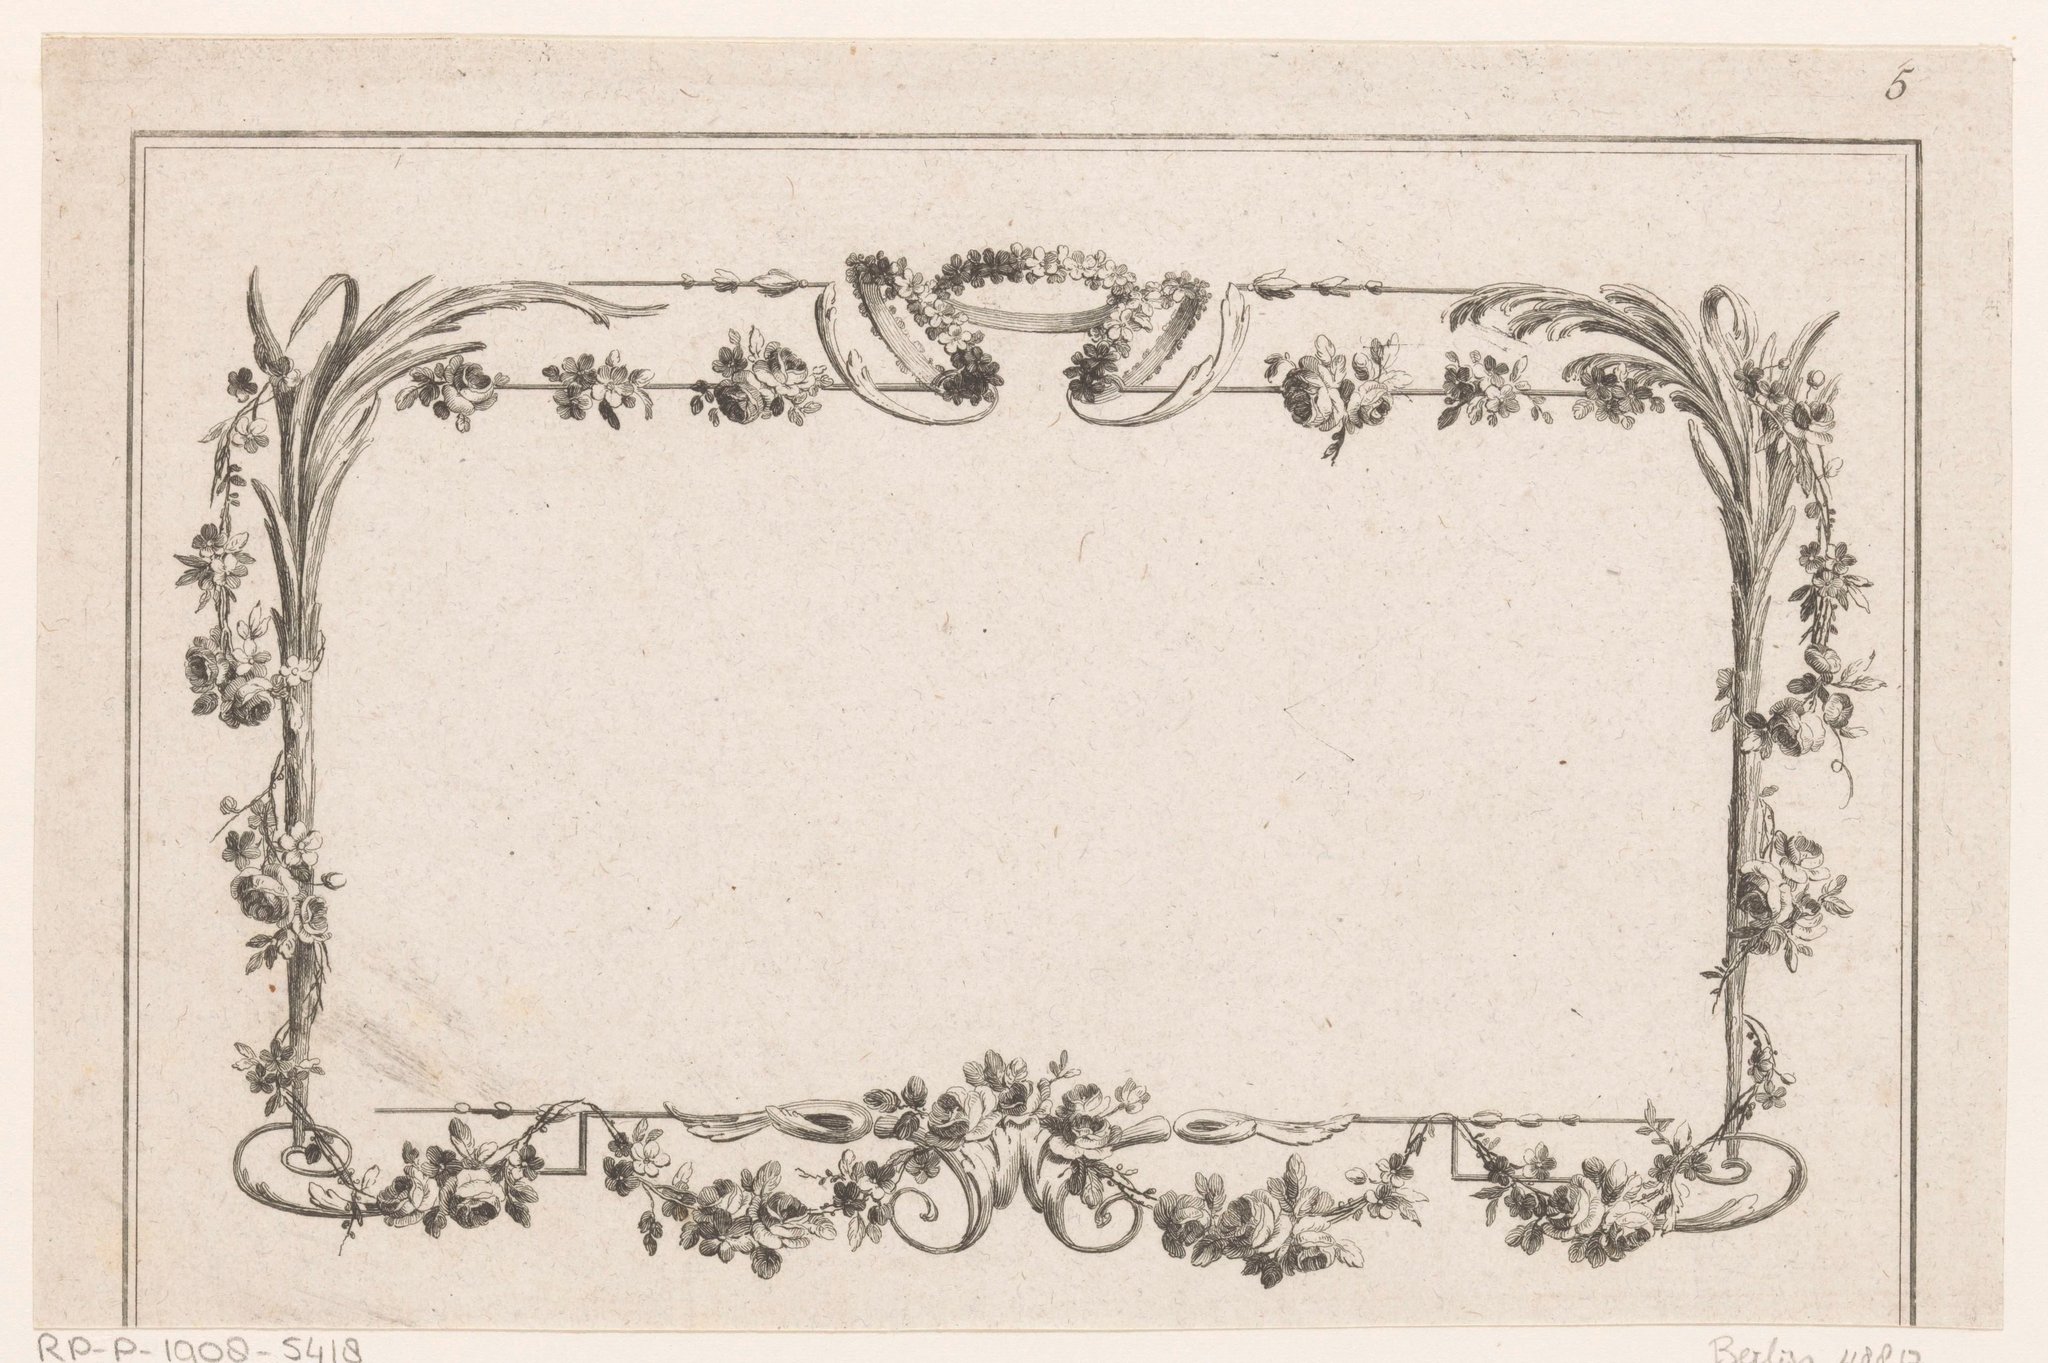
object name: ornament print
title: 17e Cahier de Cartels et Trophées de l'Oeuvre de Ranson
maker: pierre gabriel berthault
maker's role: print maker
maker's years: 1737-1819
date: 1778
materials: paper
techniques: etching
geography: paris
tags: garland, wreath, ornament ~ medallion, flowers ~ ornament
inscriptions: collector's mark: Lugt 2228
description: Een rechthoekige omlijsting met bloemen, bladmotieven en drie kransen aan de bovenzijde.